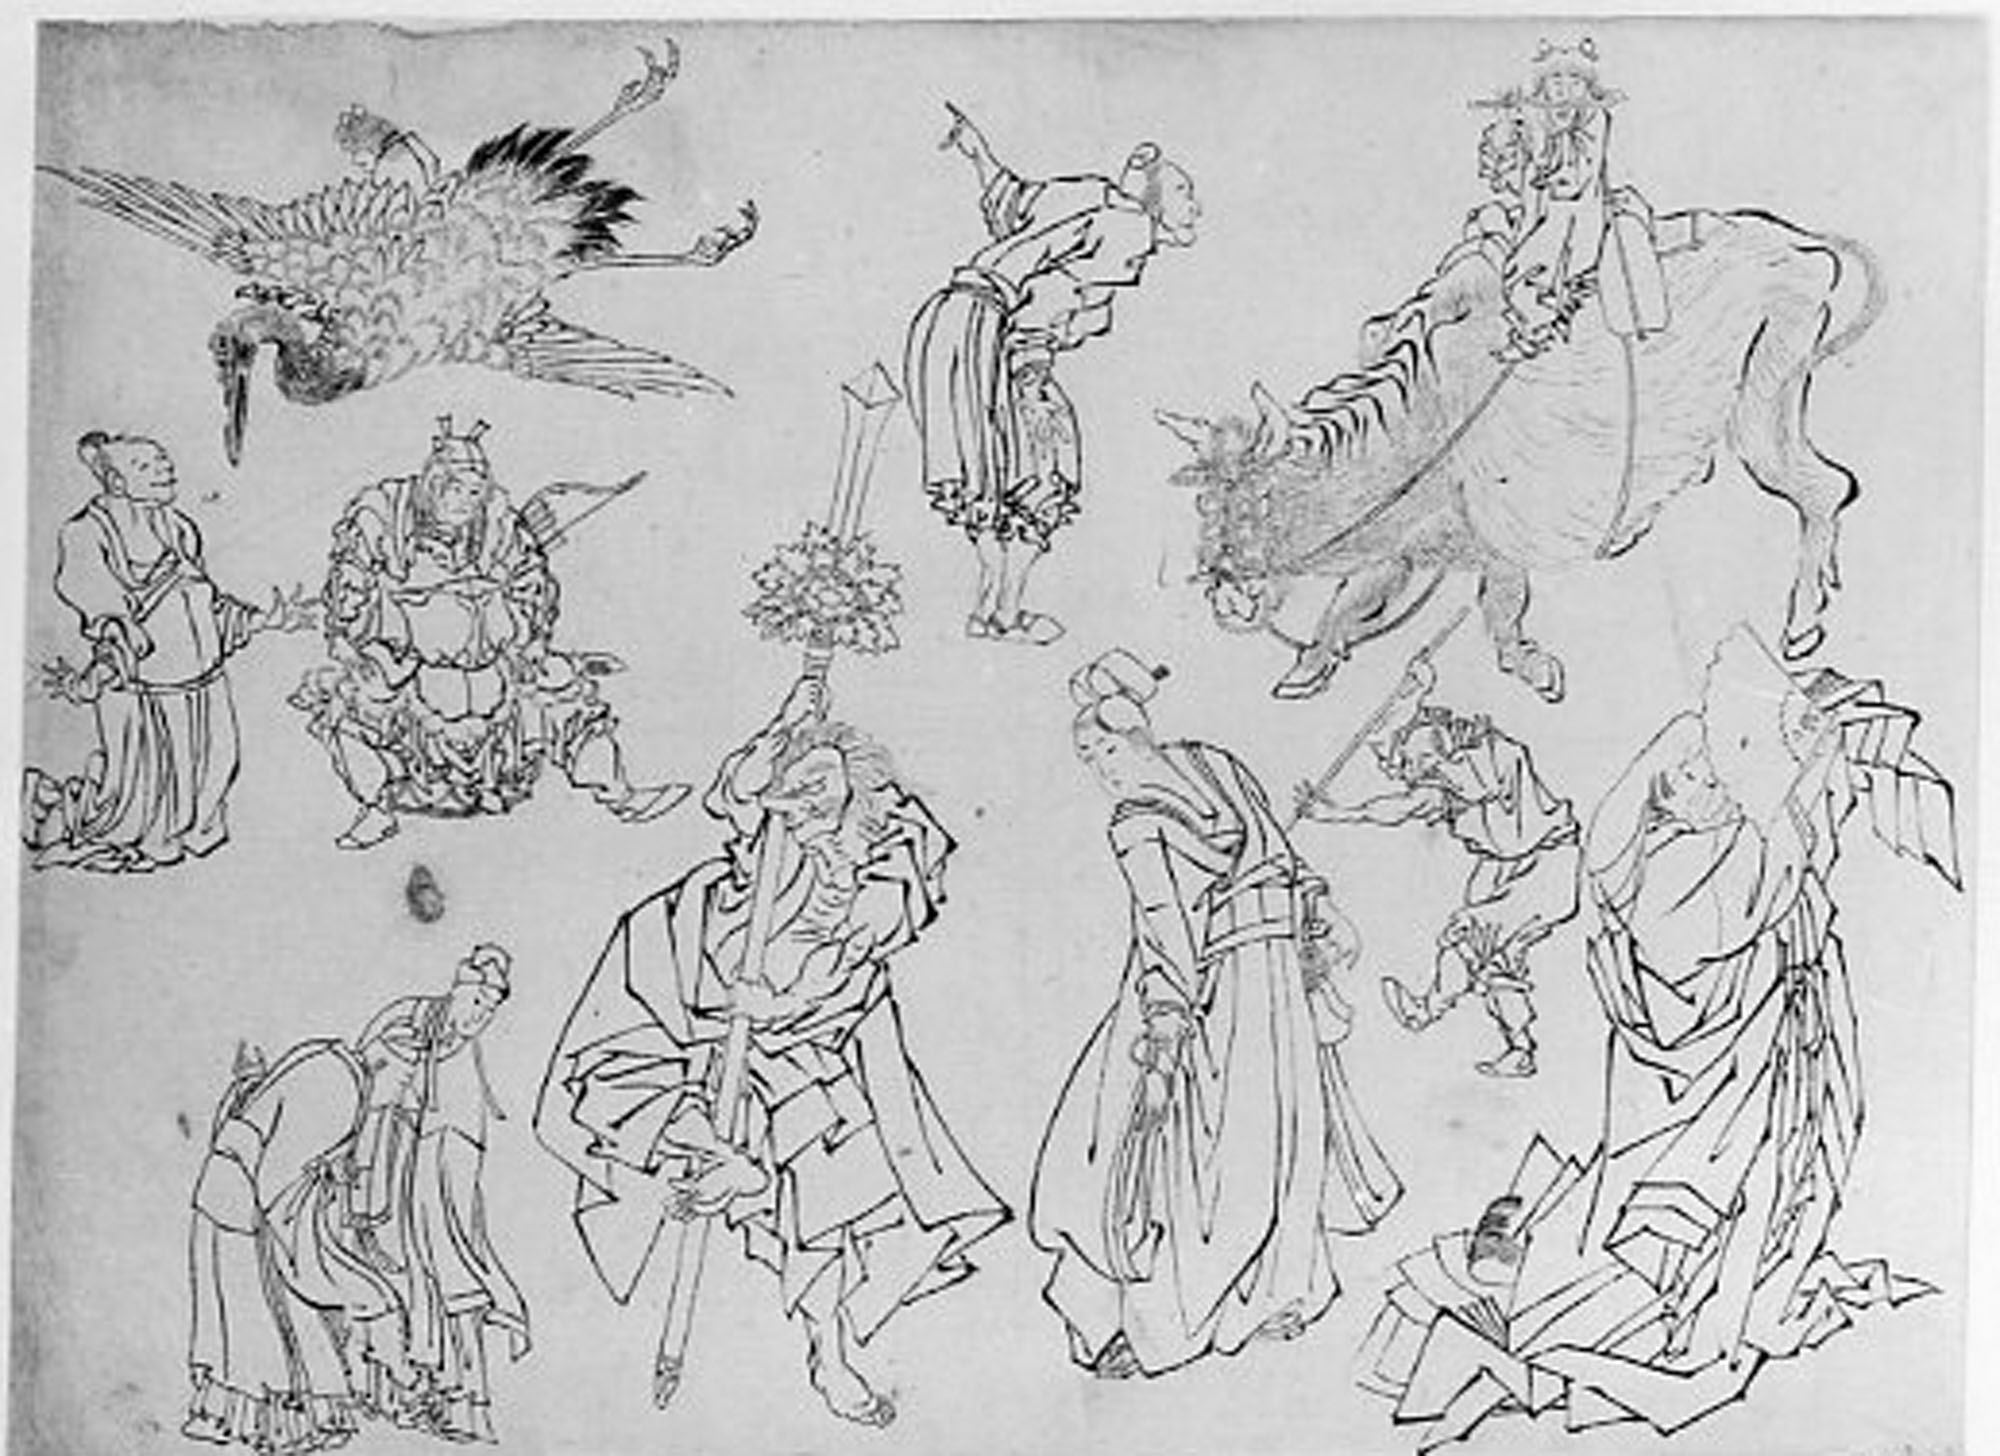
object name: painting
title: Studies of Figures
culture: japanese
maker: hokusai school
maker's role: artist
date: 1801-1900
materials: ink, paper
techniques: painting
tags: birds,men,women,ox